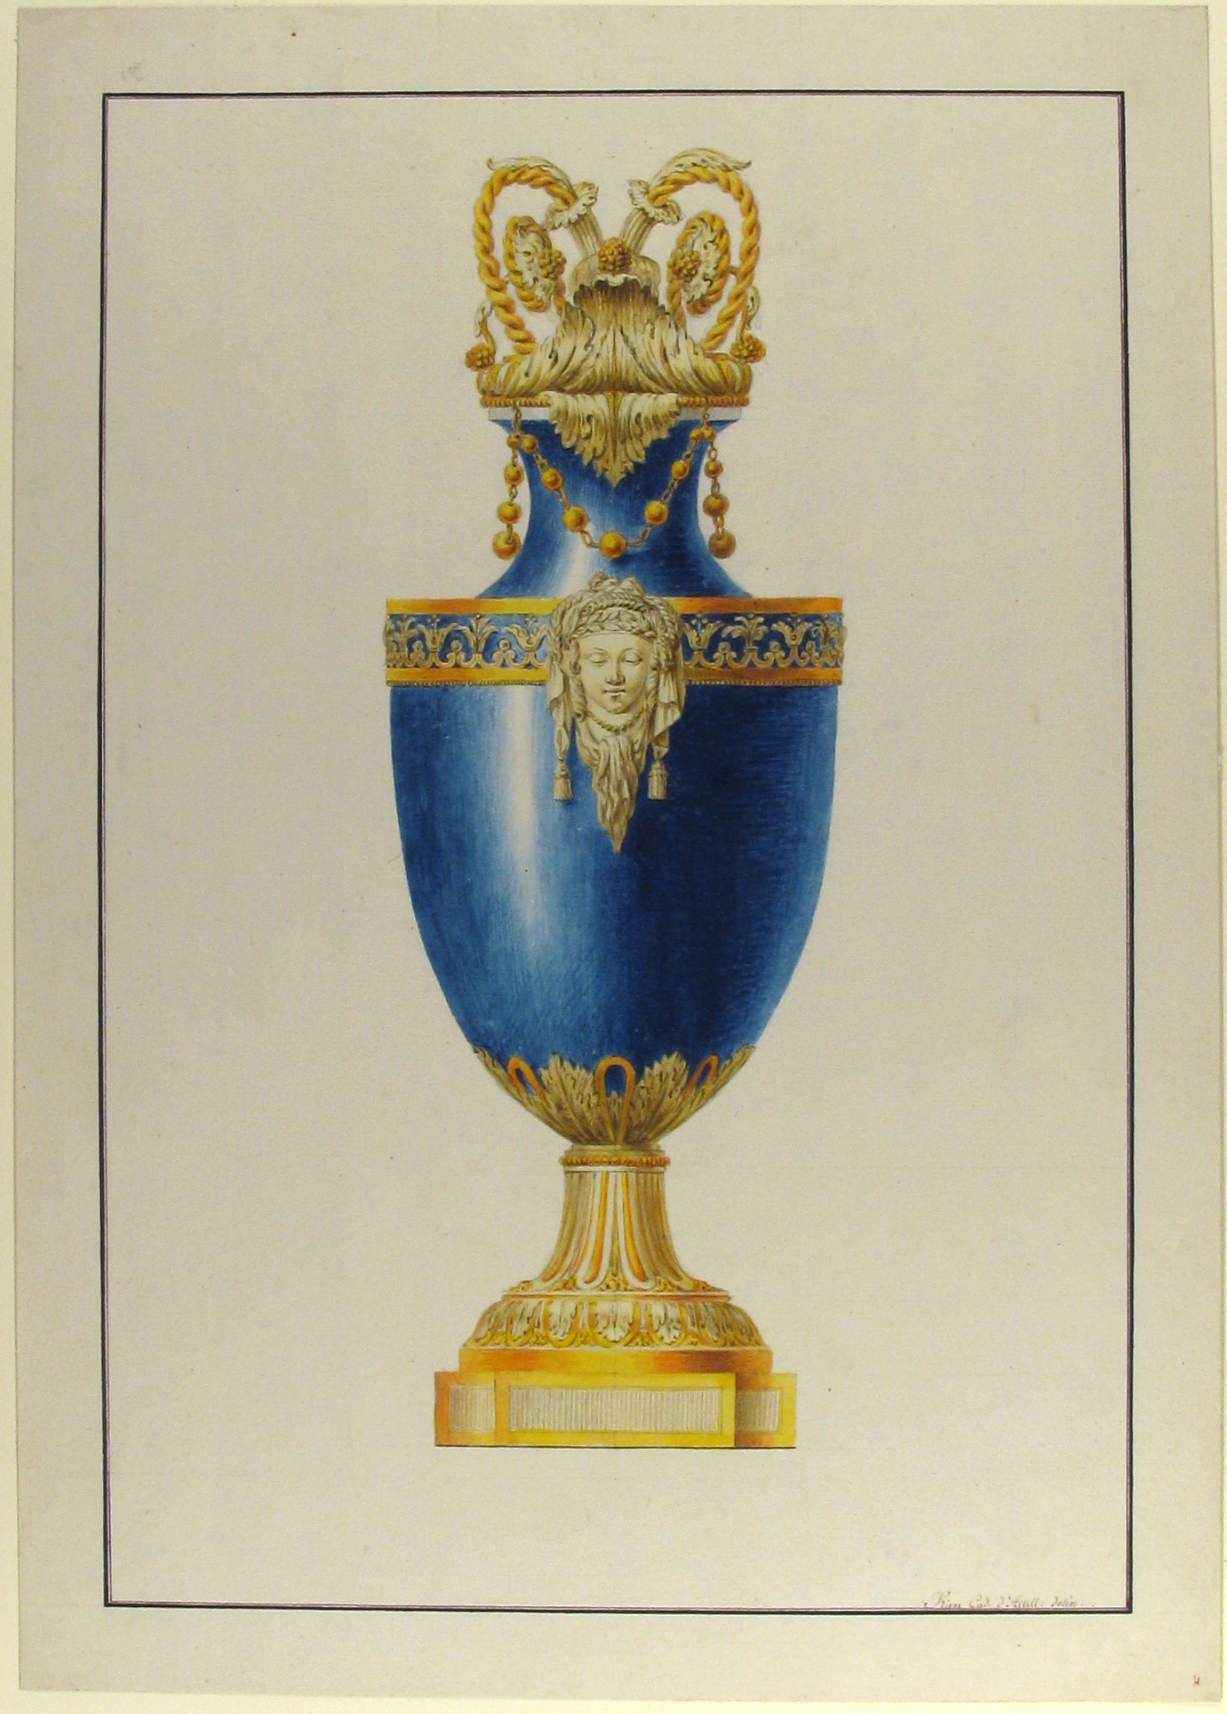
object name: drawing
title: Design for an Urn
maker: george heinrich von kirn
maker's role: artist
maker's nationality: german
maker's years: 1736-1793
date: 1770-1790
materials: chalk, ink, watercolor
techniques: brush, pen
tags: faces,urns